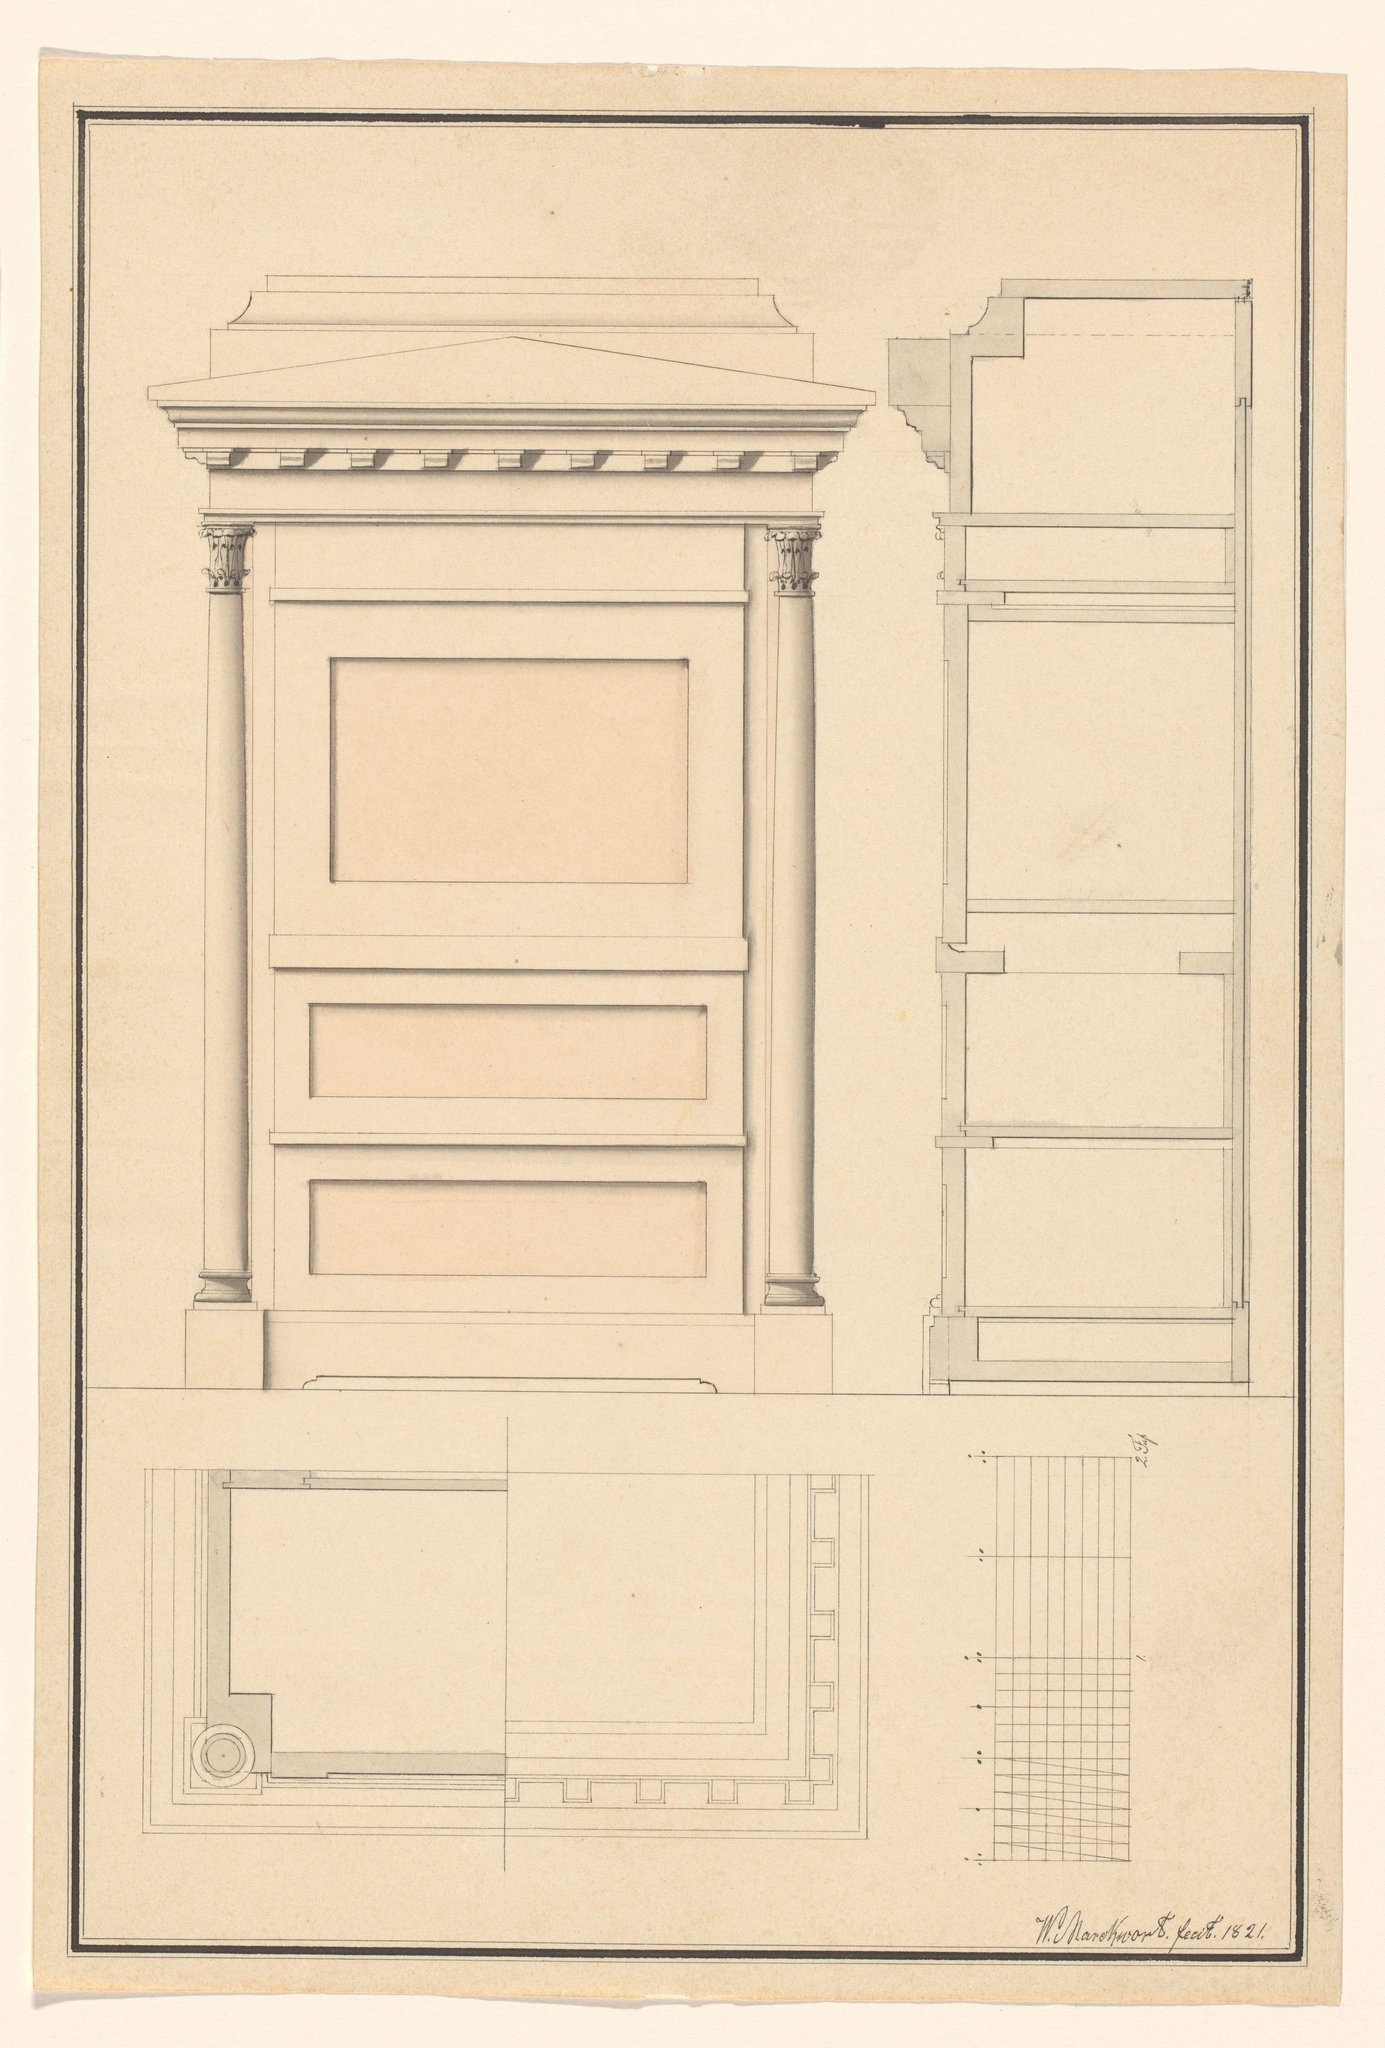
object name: design drawing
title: Ontwerp voor een secretaire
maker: carl wilhelm marckwort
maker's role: draughtsman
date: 1821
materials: ink, paper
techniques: brush, pen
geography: berlin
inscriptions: signature and date: ‘W. Marckwort. fecit. 1821.’, inscription: ‘2. Fuβ’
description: Rechthoekige verdiepte velden, voor- en zijaanzicht, met daaronder een in tweeën gedeelde plattegrond en een maatverdeling.